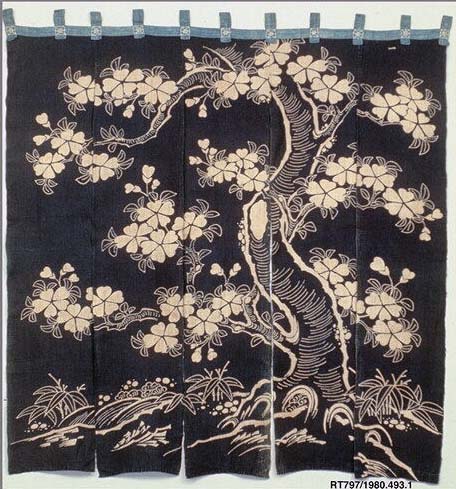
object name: door curtain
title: Noren with Design of Flowering Cherry Tree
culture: japanese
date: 1801-1900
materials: hemp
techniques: dyeing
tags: flowers,trees